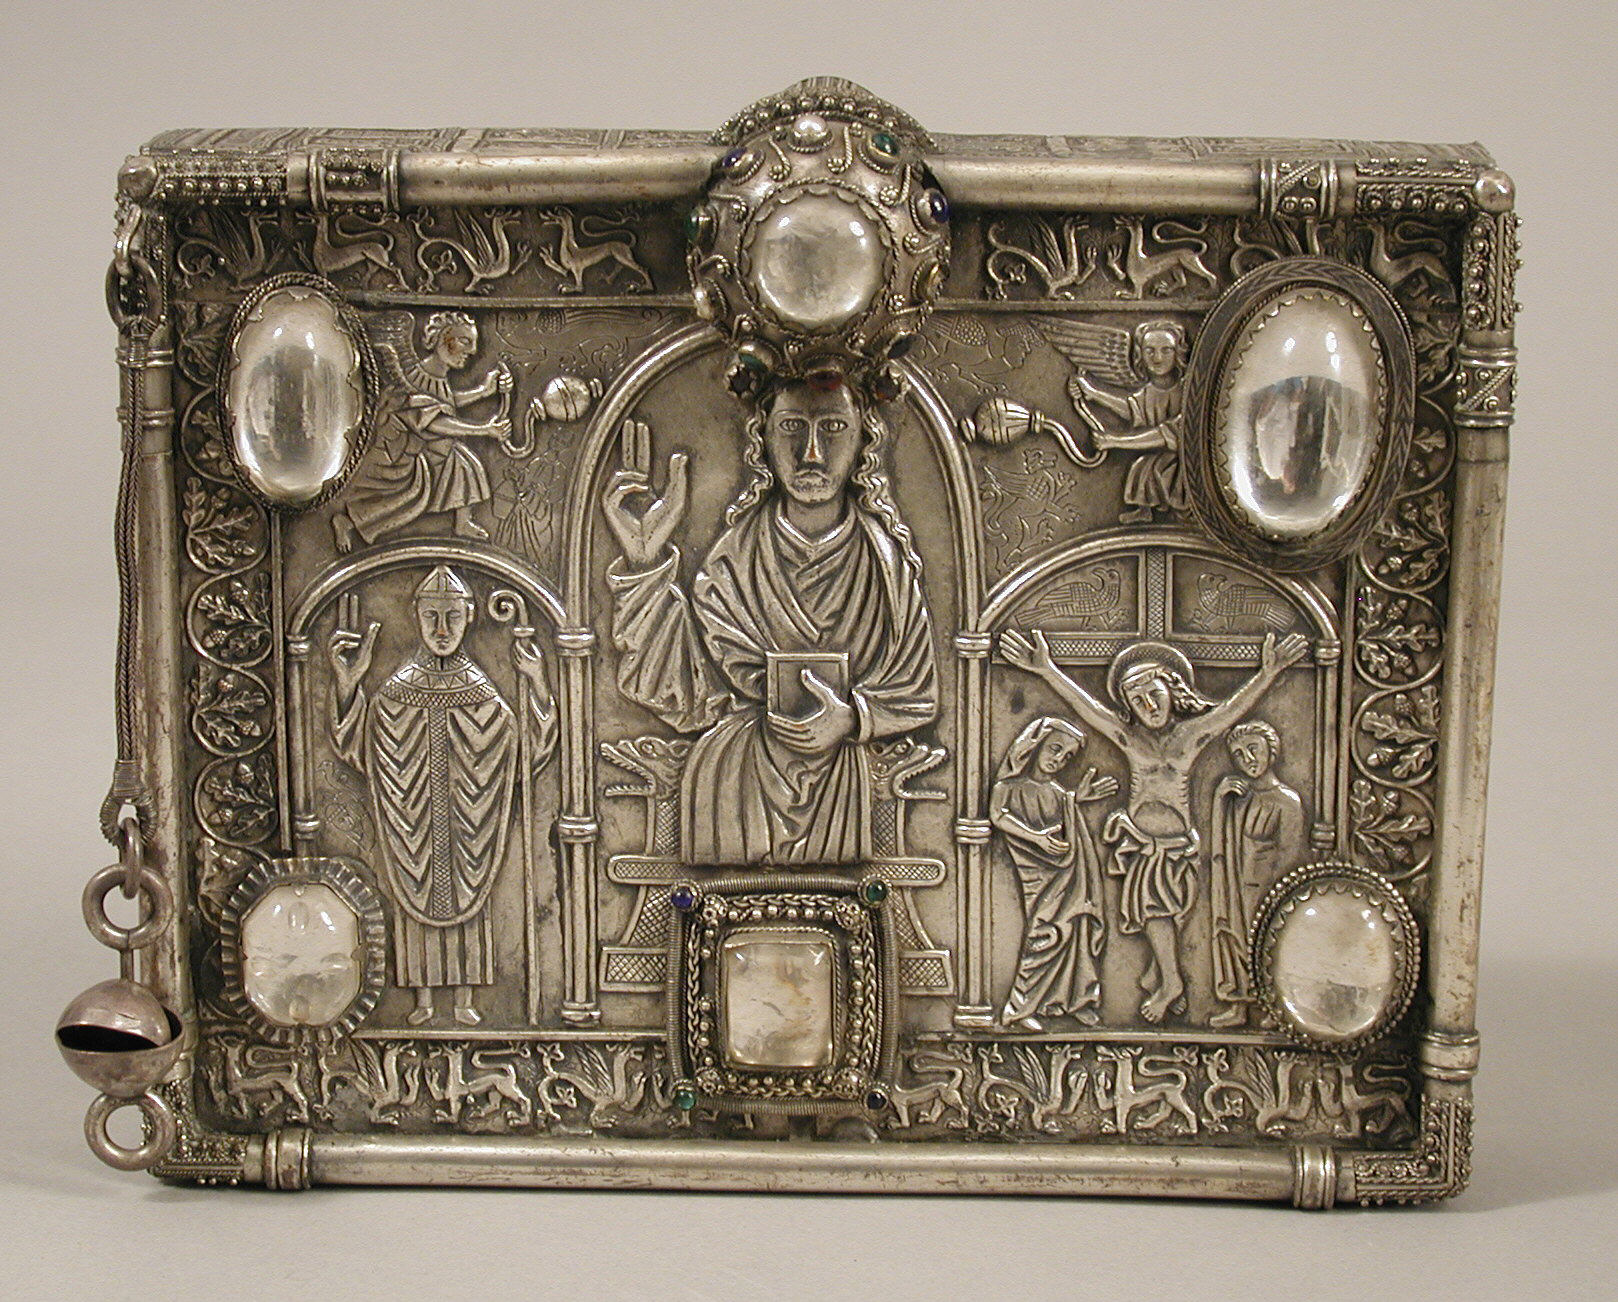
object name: shrine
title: Shrine of O'Donnell, Cathach or Battler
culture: irish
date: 1901-1933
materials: bronze, stone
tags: angels,christ,reliquaries,saints